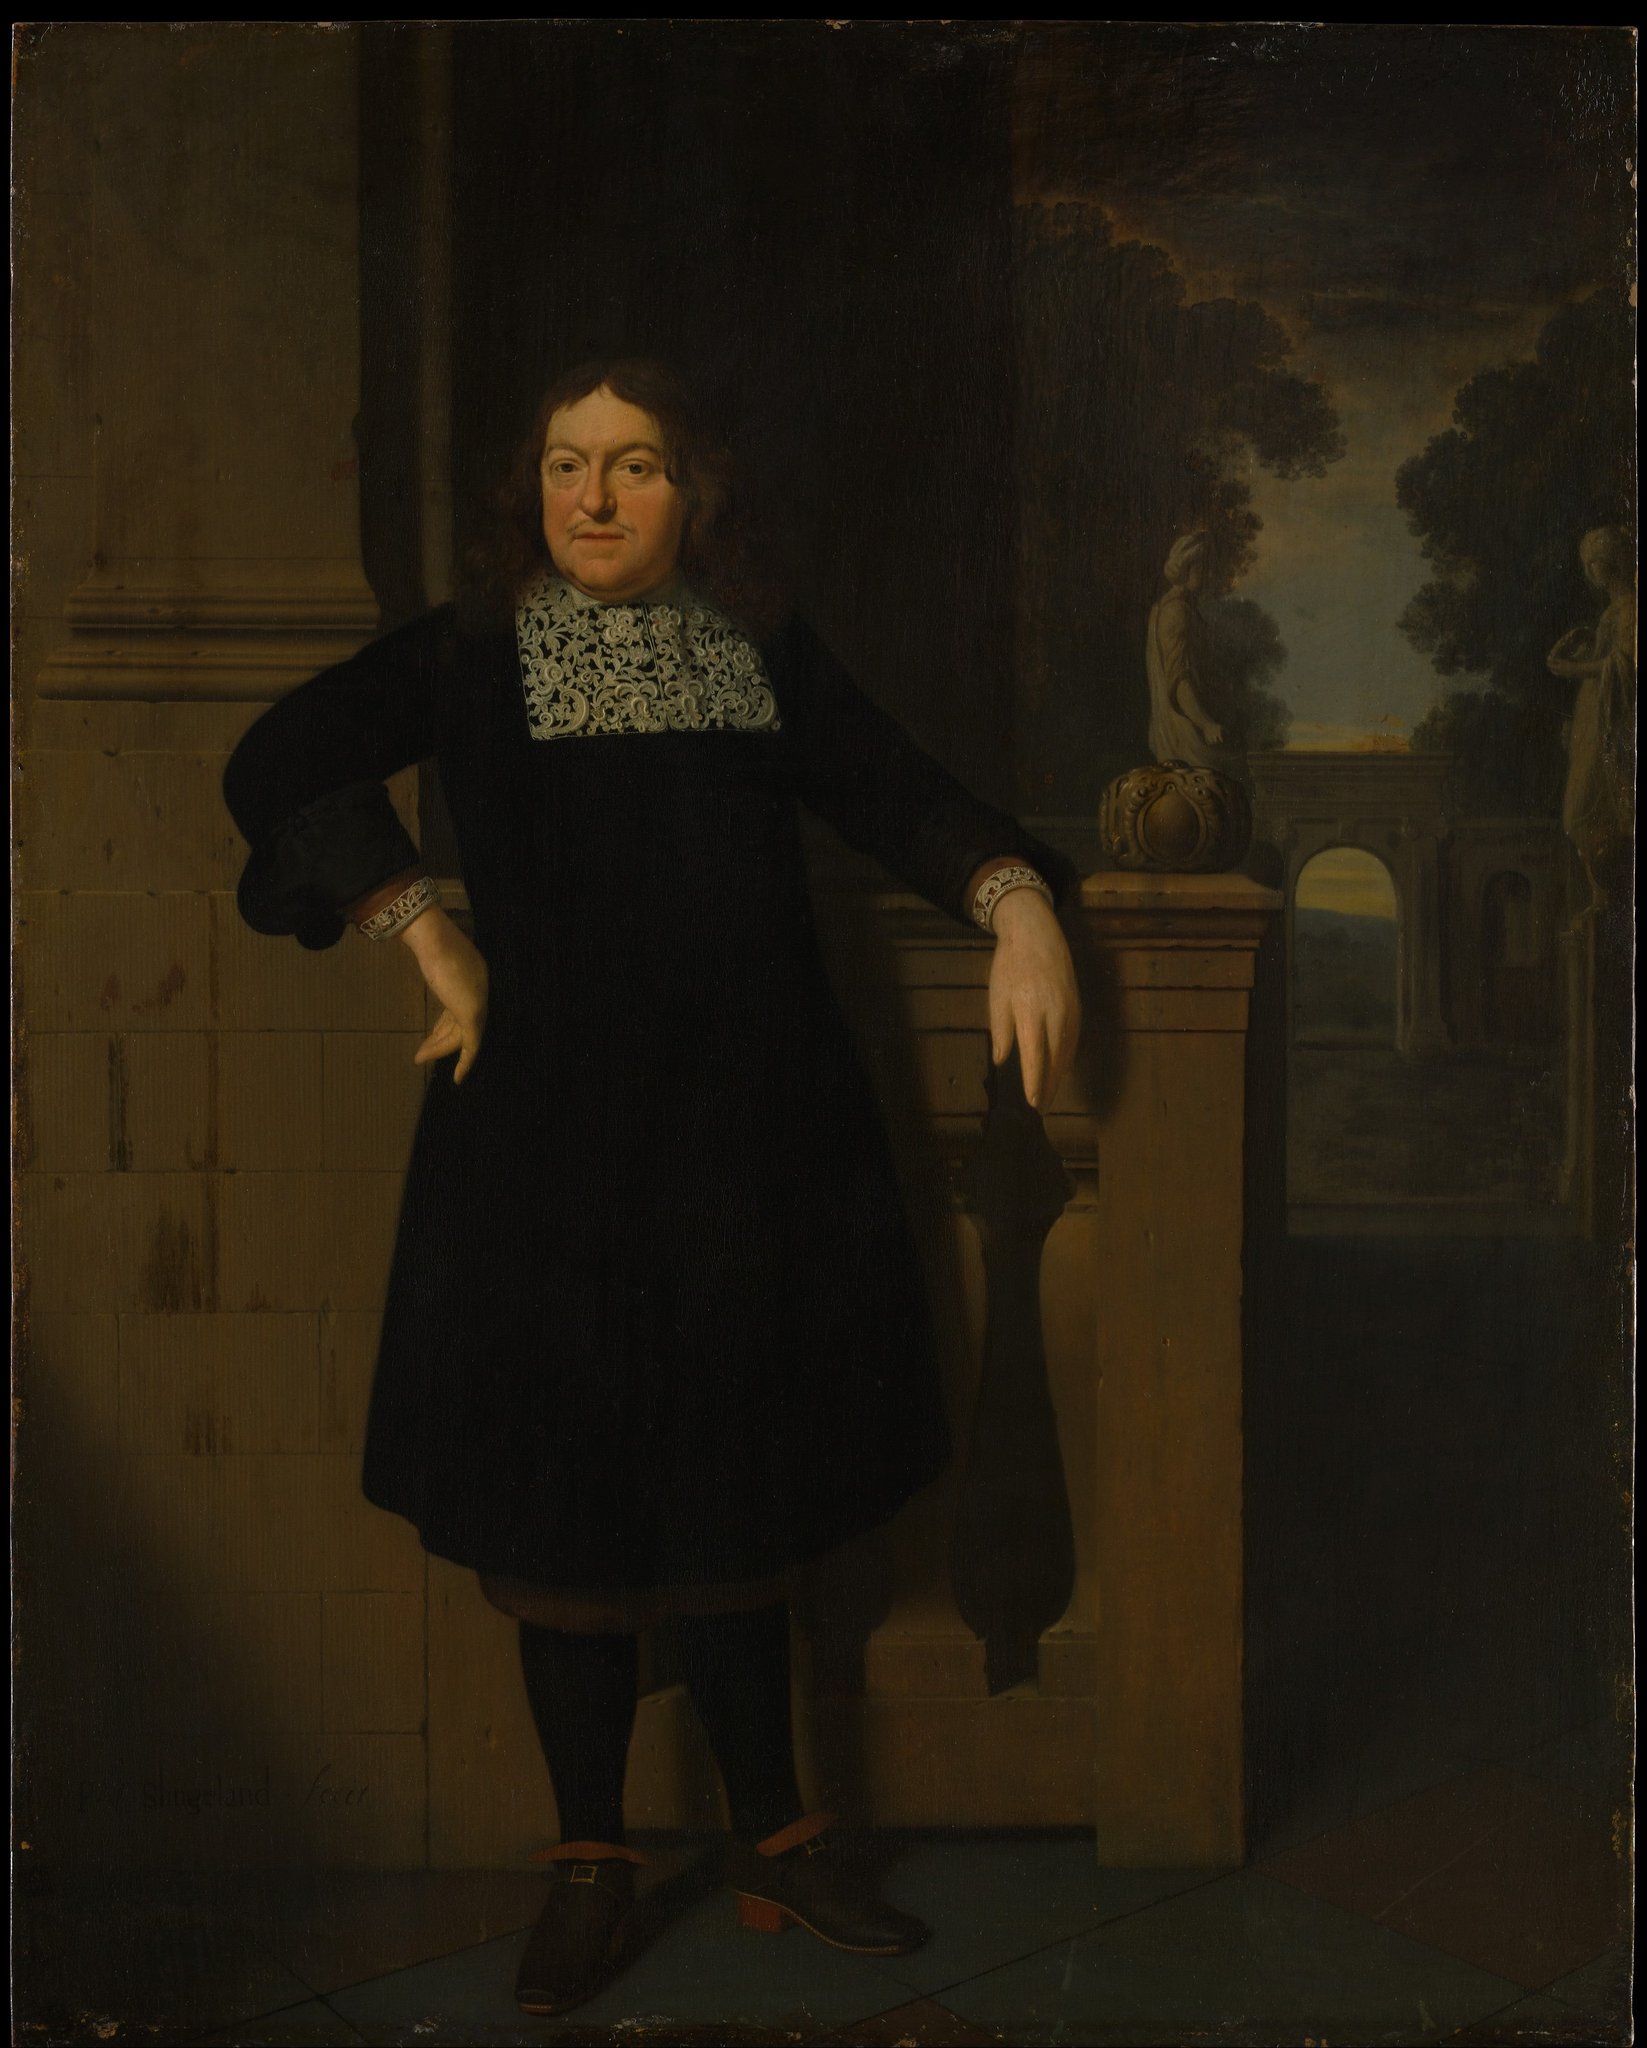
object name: painting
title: Johan Hulshout (1623–1687)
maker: pieter van slingelandt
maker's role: artist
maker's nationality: dutch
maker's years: 1640-1691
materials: oil, wood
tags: men,portraits